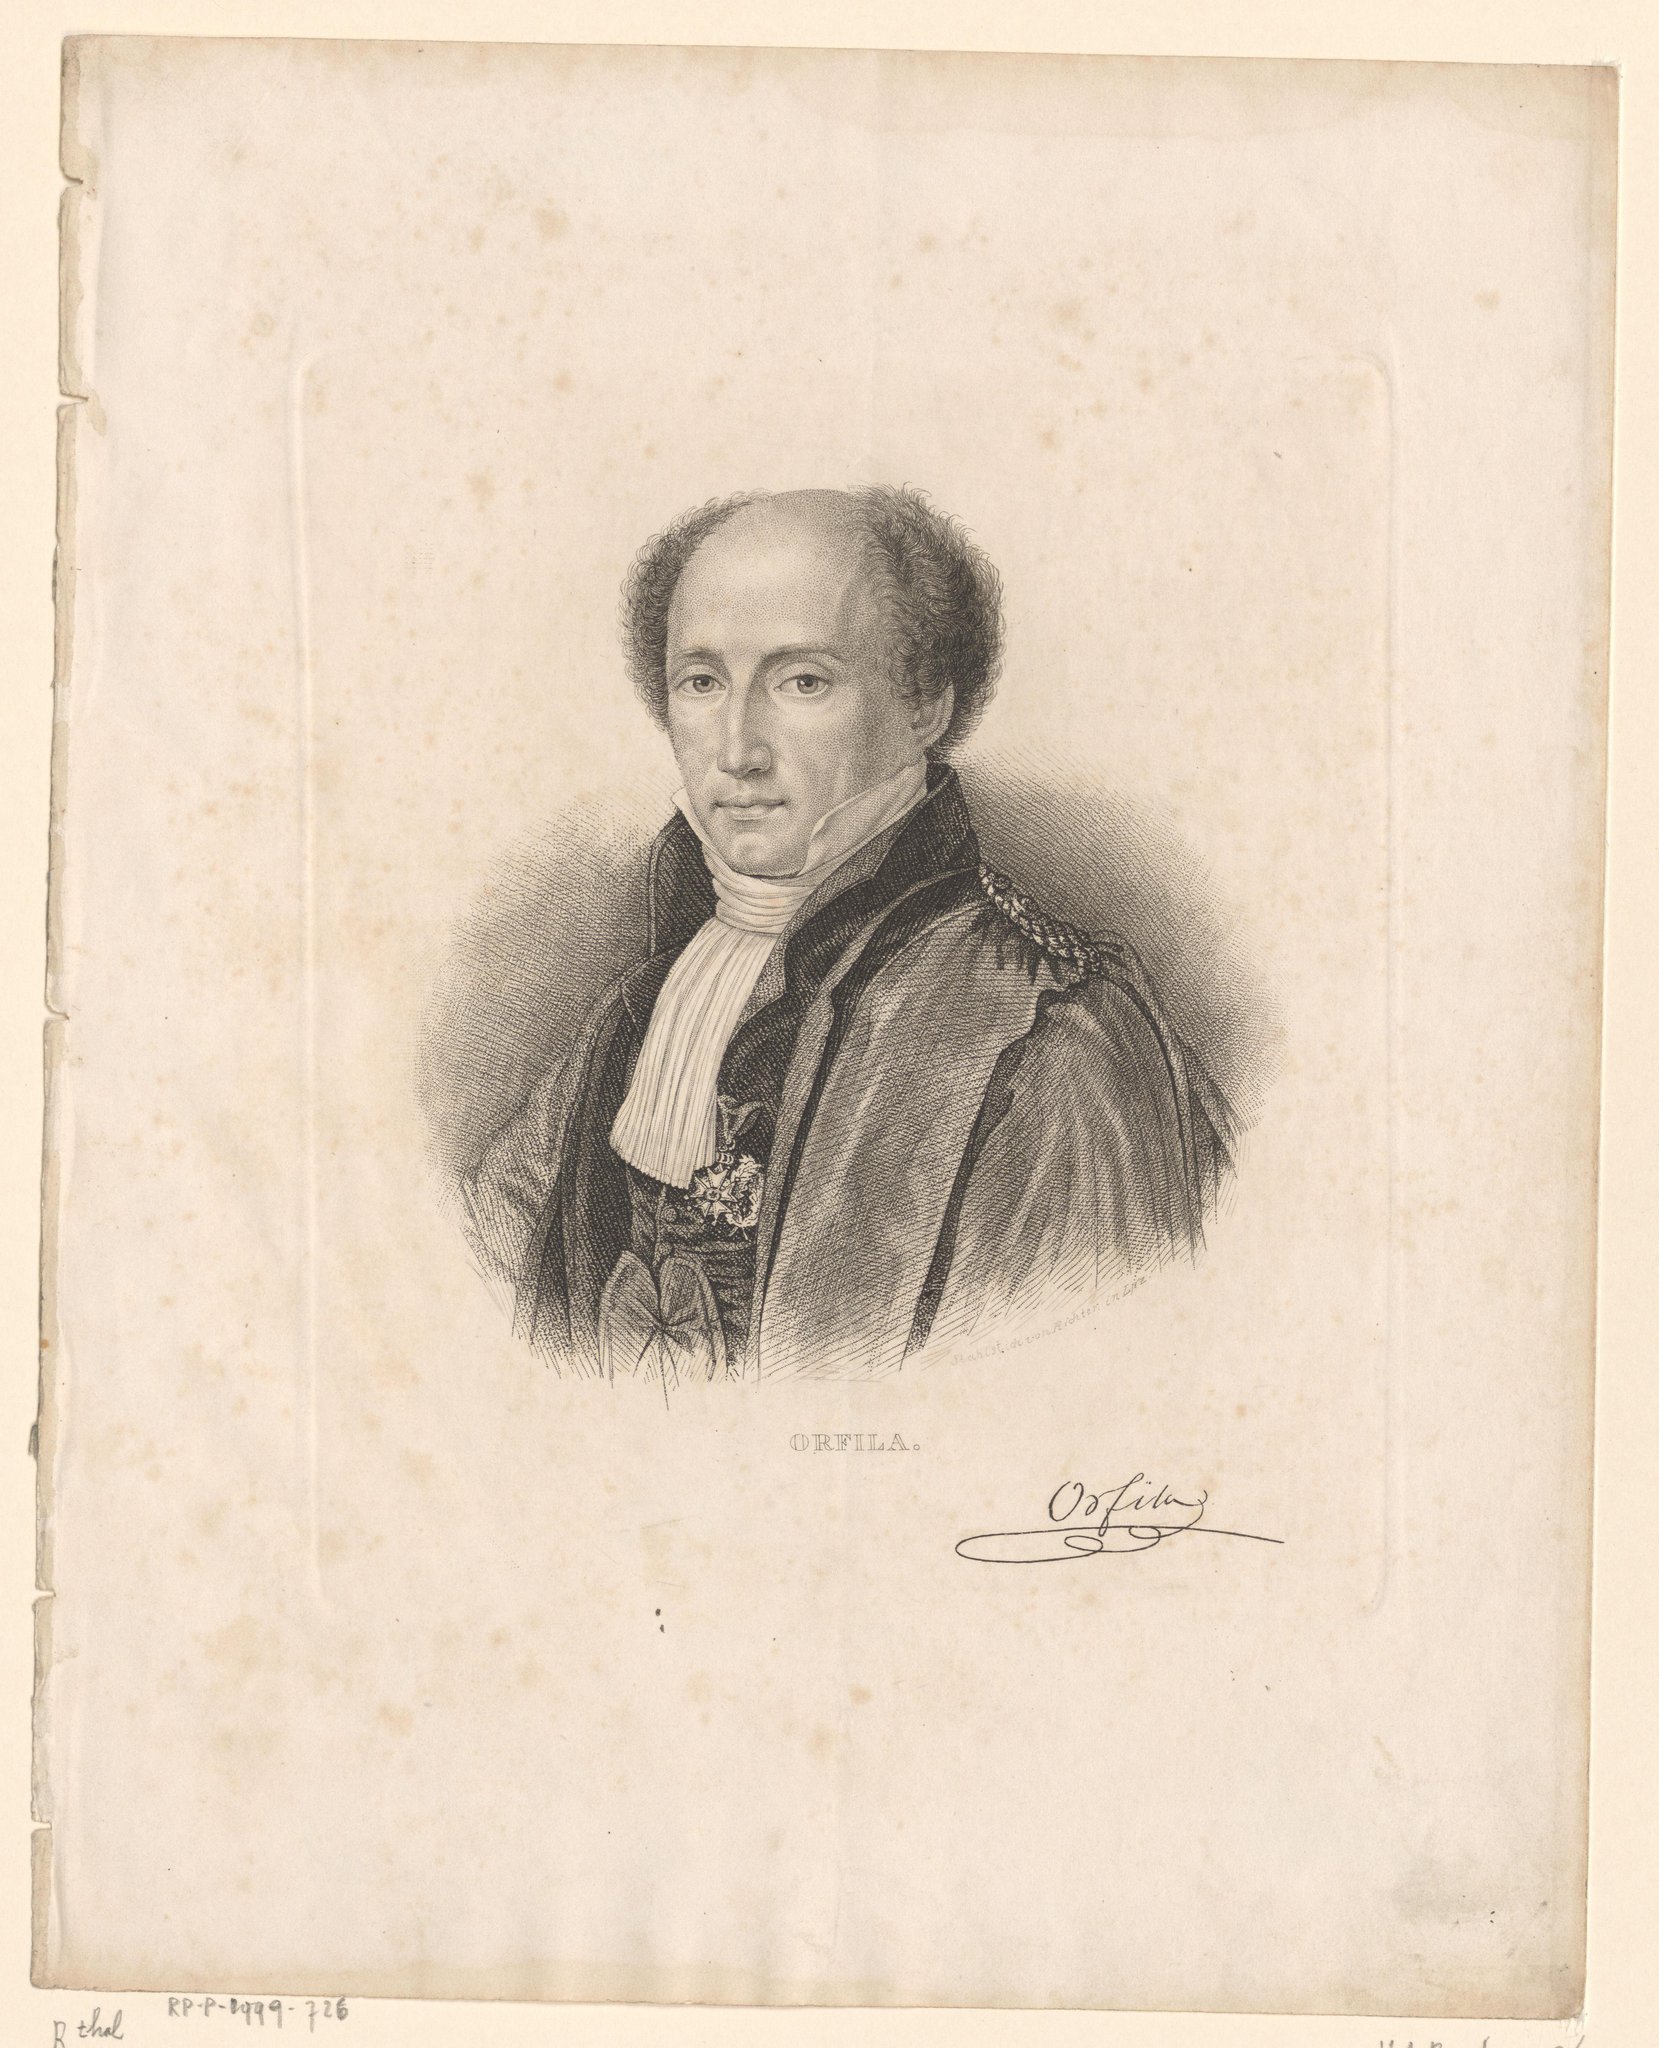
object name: print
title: Portret van Mathieu-Joseph Bonaventure Orfila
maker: f. richter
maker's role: print maker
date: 1807-1899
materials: paper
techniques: roulette, engraving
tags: historical persons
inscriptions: collector's mark: Lugt 2228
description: Portret van de medicus en chemicus Mateo José Buenaventura Orfila: buste naar links.